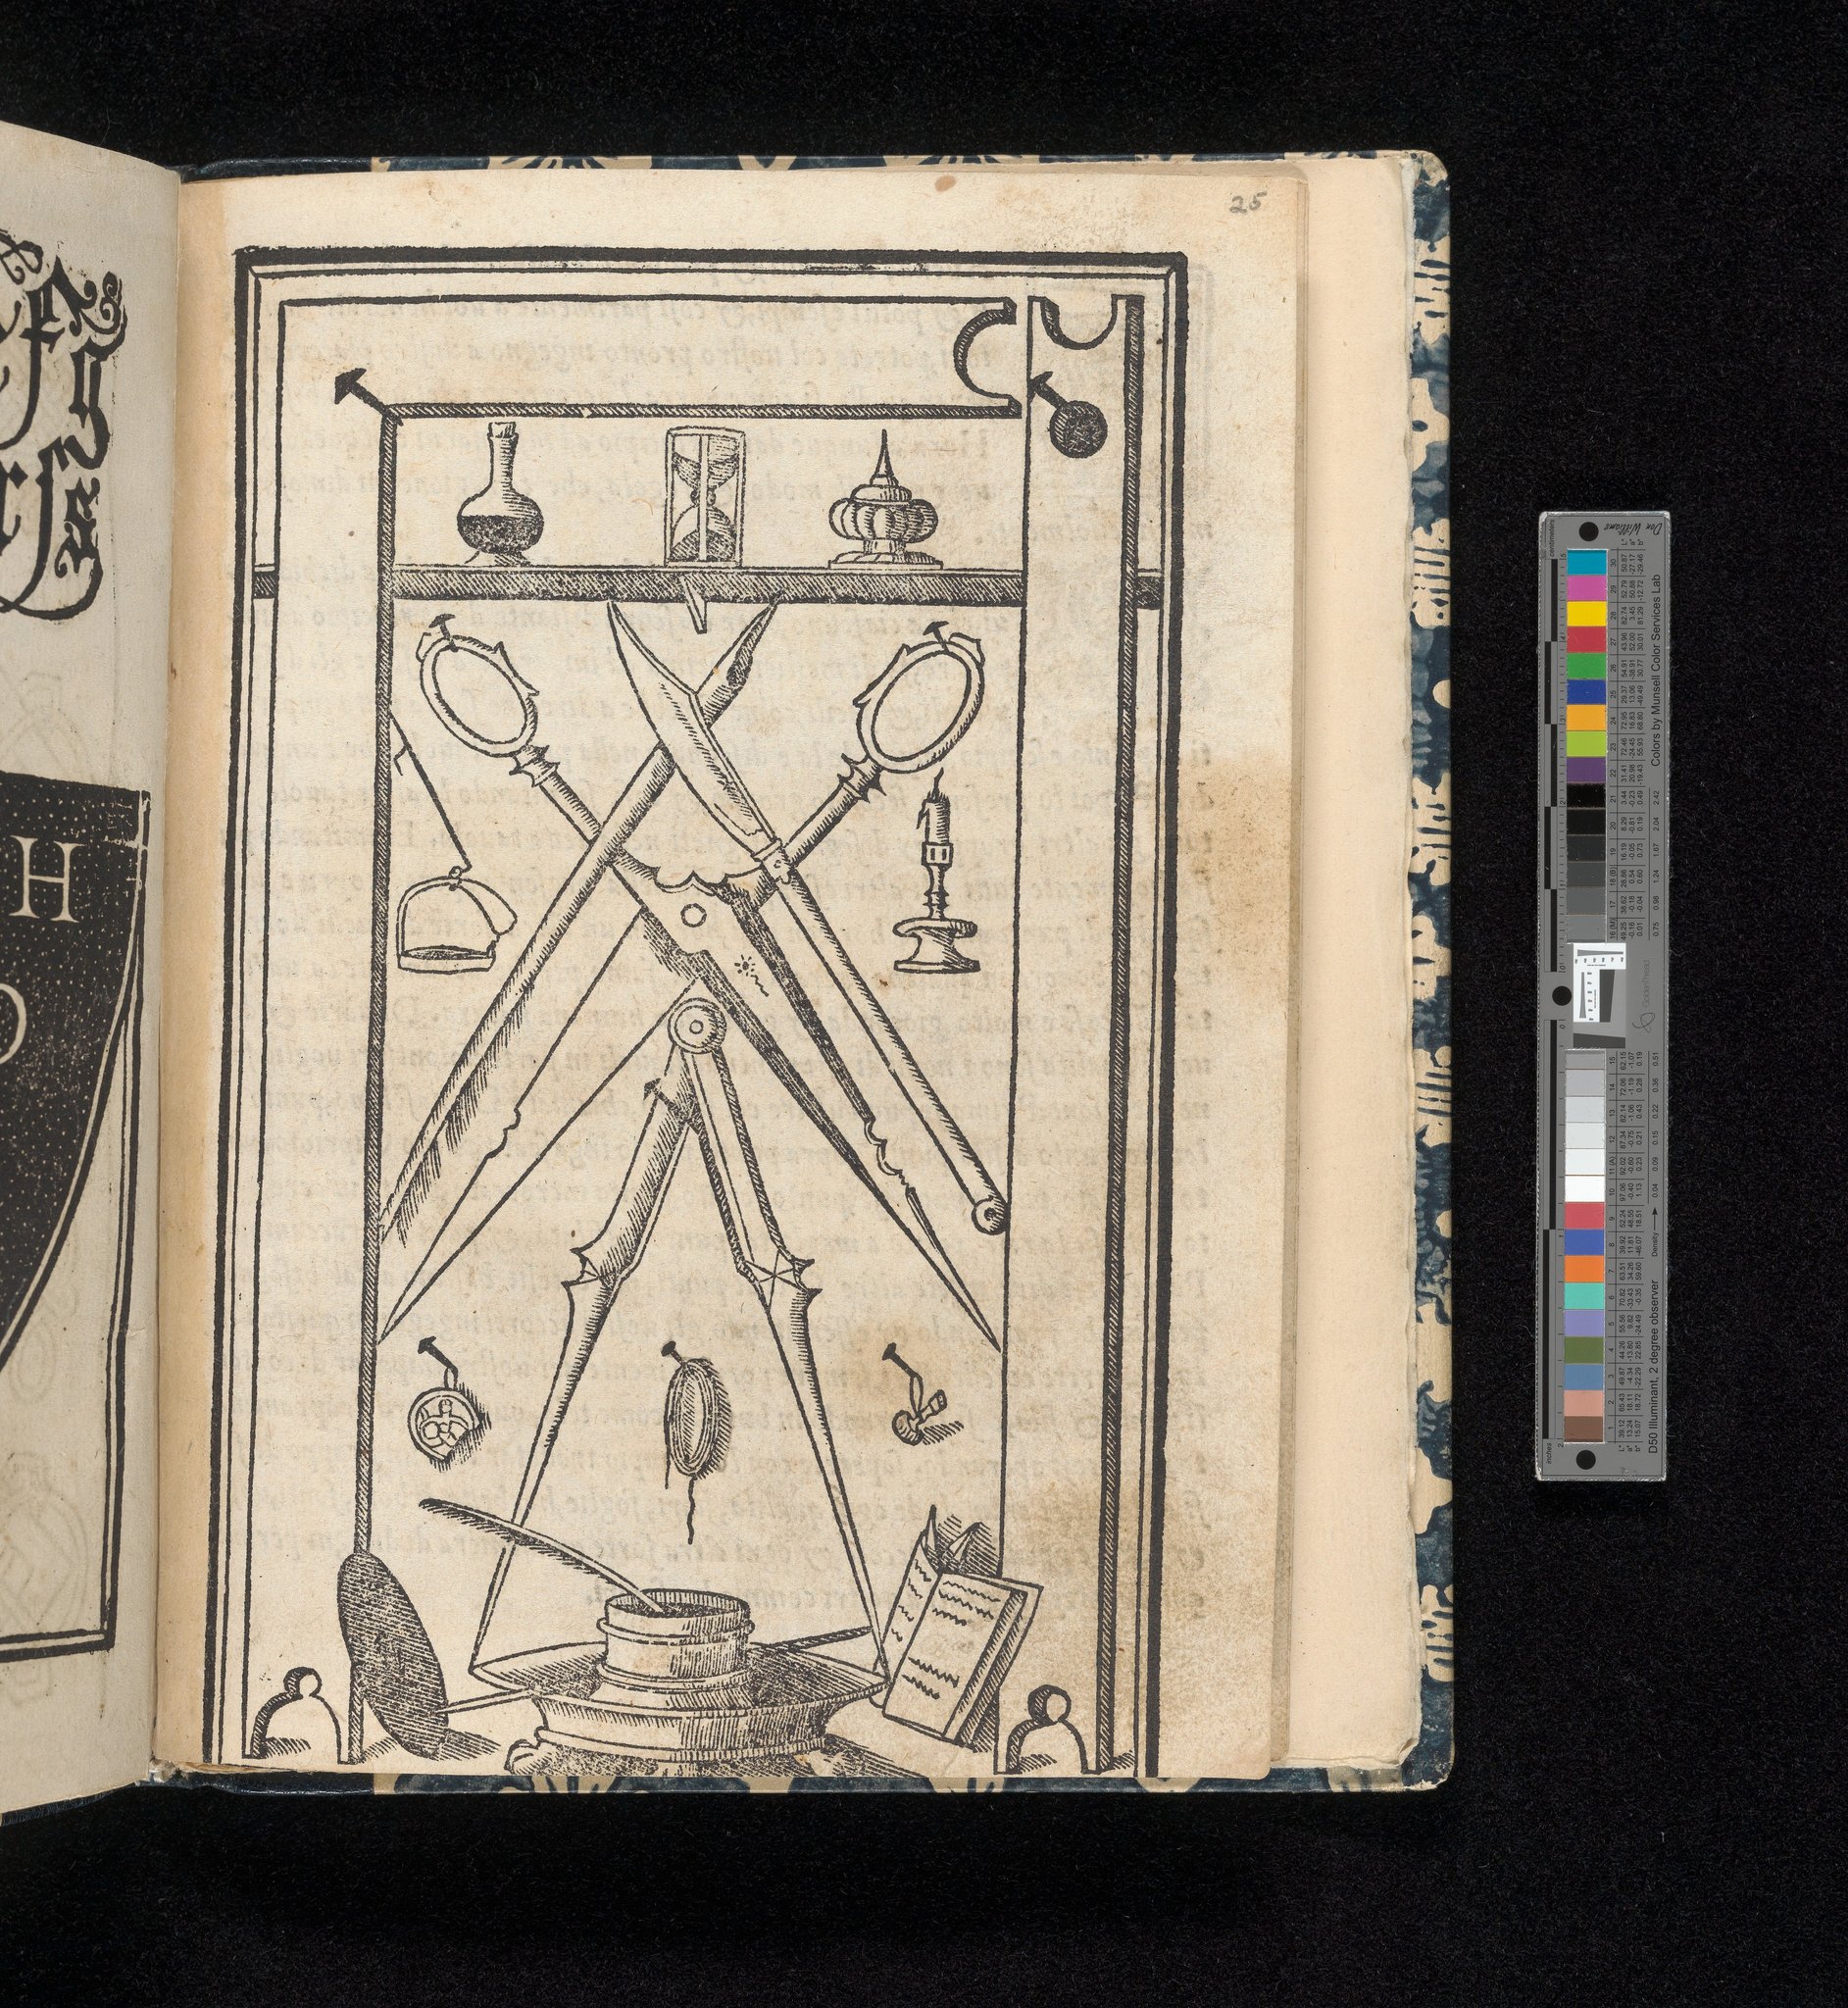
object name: book print ornament architecture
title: Essempio di recammi, page 25 (recto)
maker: giovanni antonio tagliente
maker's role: author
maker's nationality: italian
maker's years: 1465-1528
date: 1530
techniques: woodcut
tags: tools